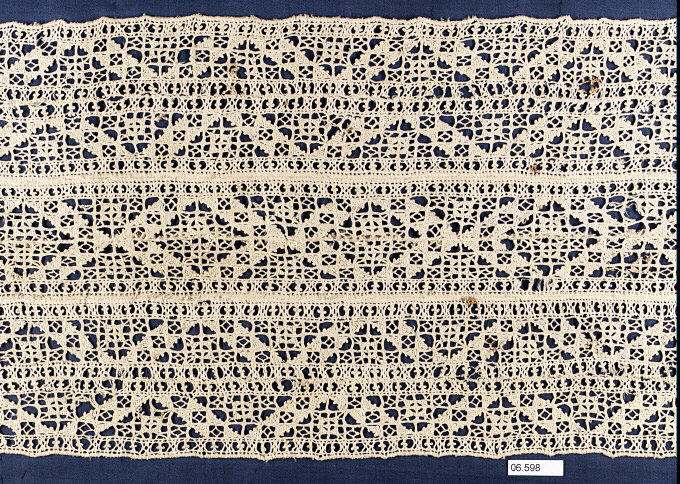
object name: insertion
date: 1567-1600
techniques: lace